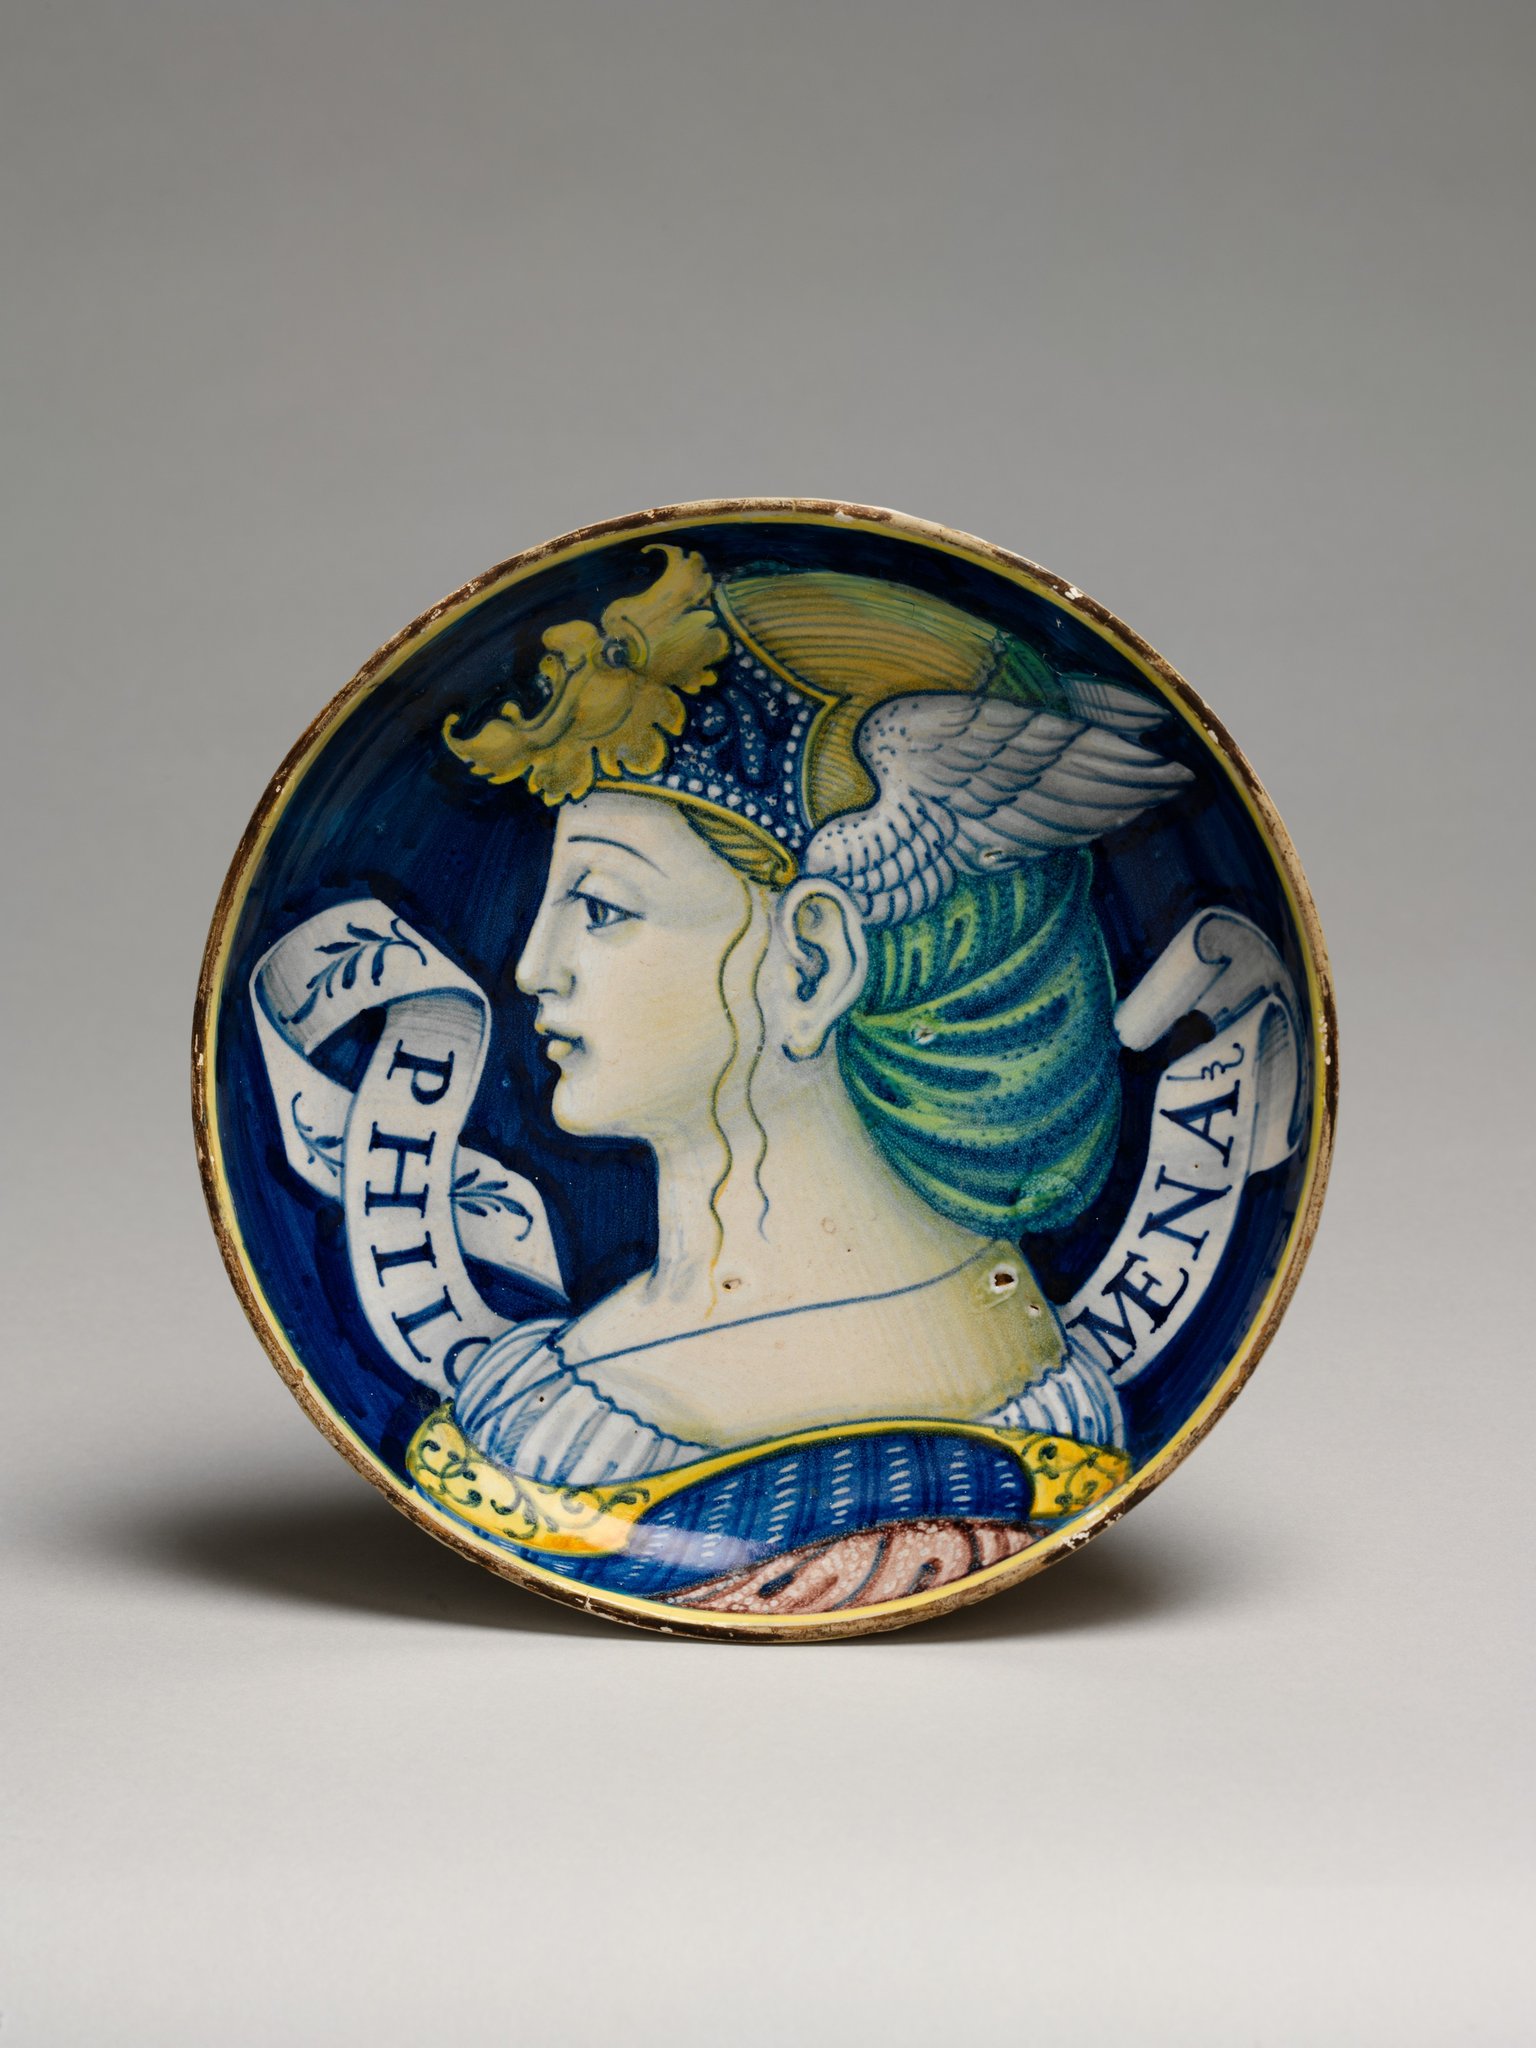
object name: plate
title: Plate (one of a pair)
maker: nicola da urbino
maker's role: maker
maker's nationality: italian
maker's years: 1520-1538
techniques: maiolica, glazing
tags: profiles,women